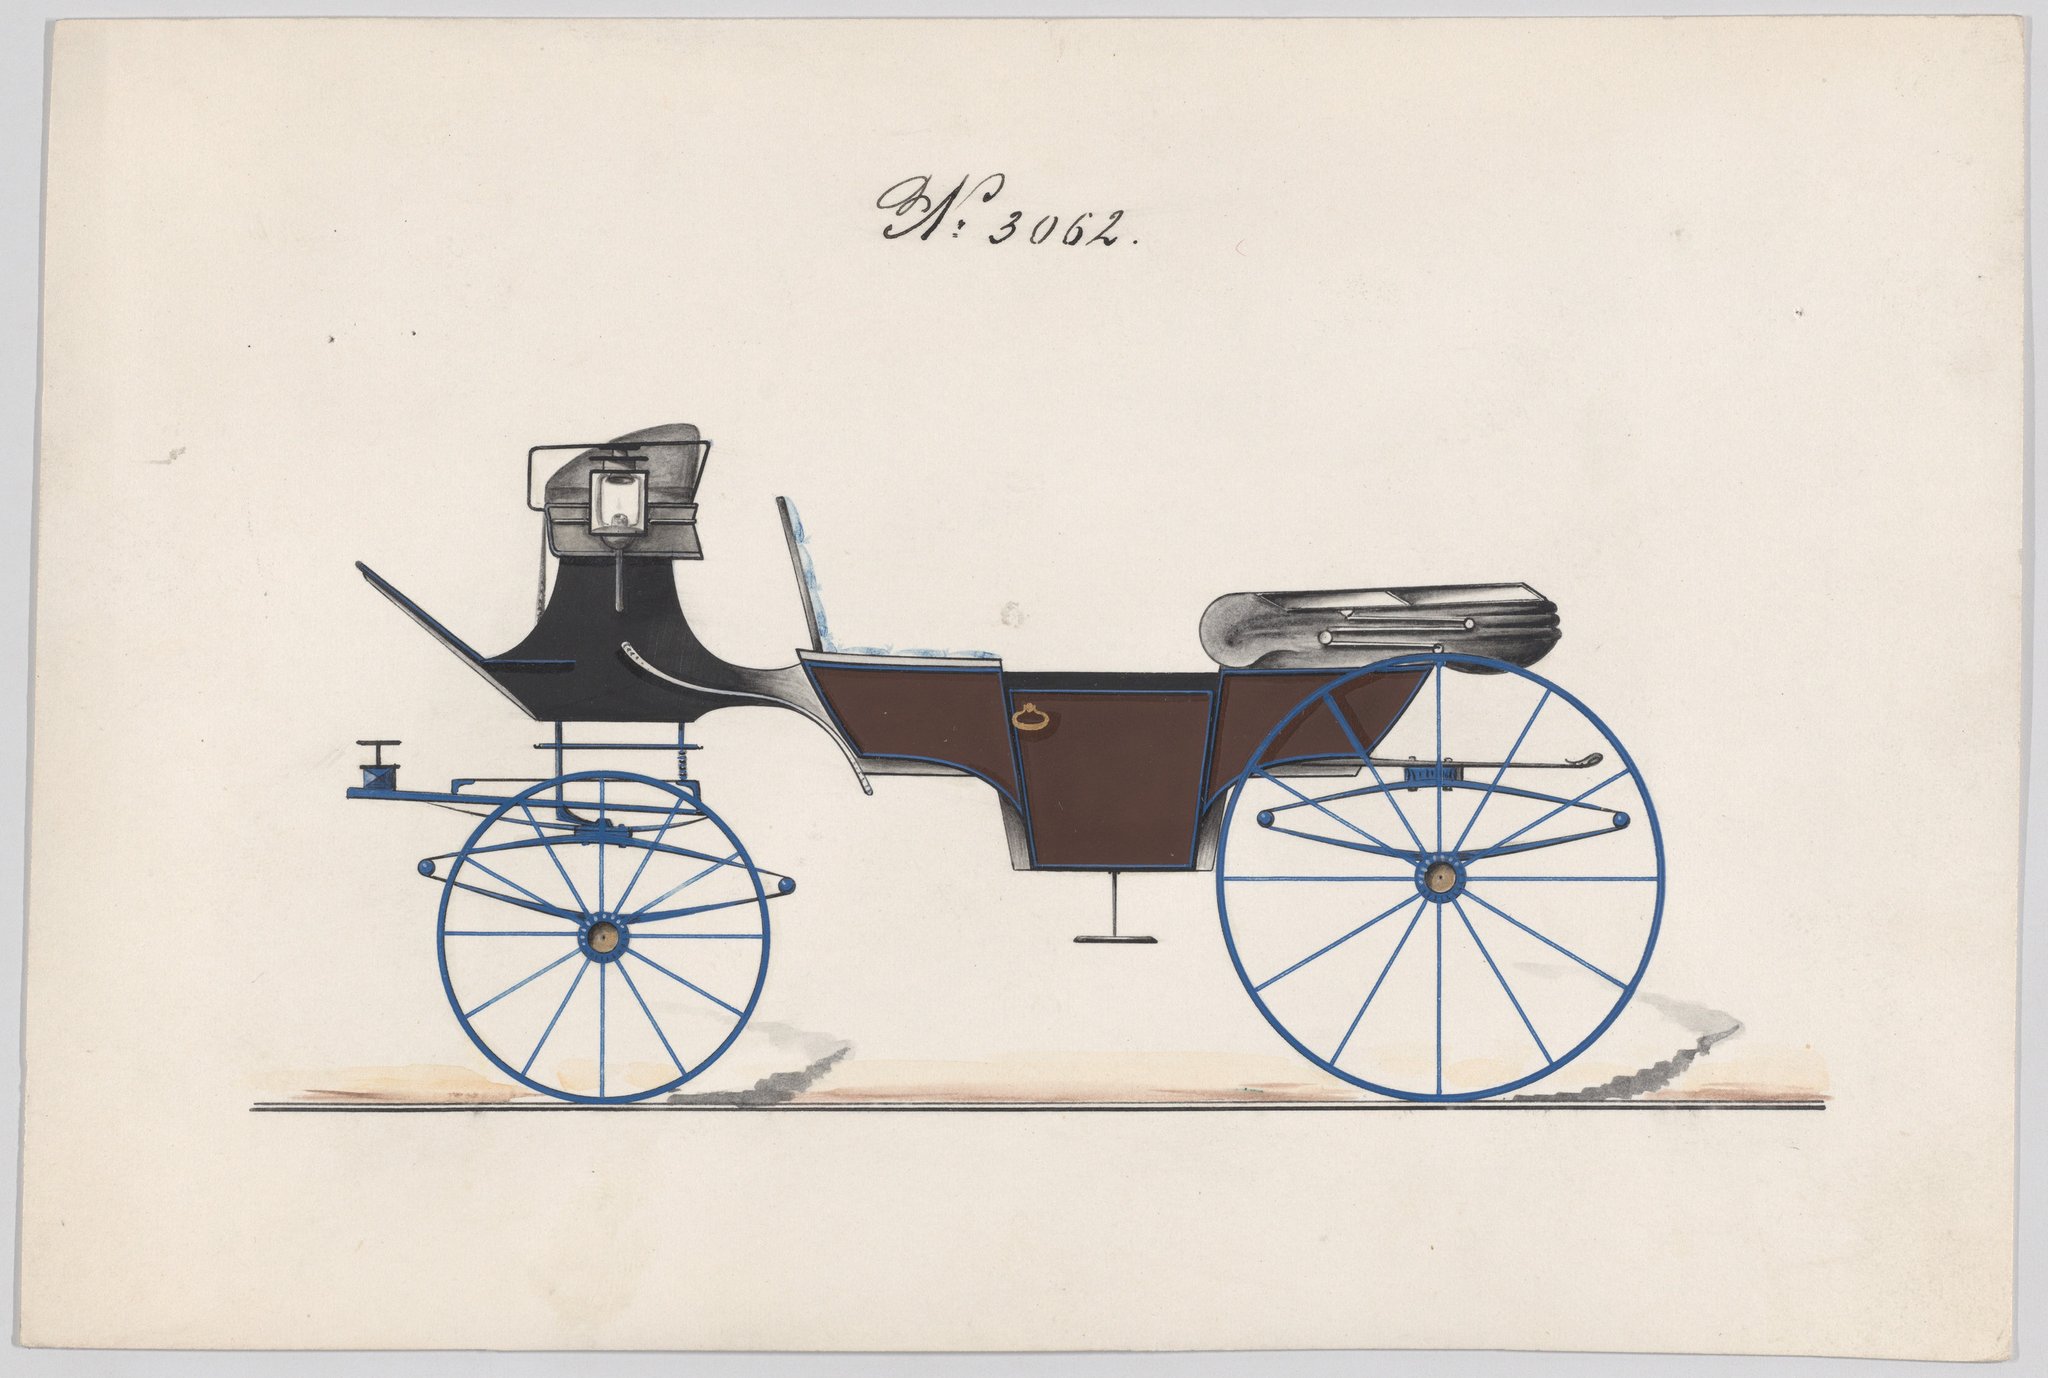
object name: drawing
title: Vis-à-vis/Brett #3062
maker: brewster & co.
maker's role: manufacturer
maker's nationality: american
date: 1874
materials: gouache, gum arabic, ink, watercolor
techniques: pen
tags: carriages